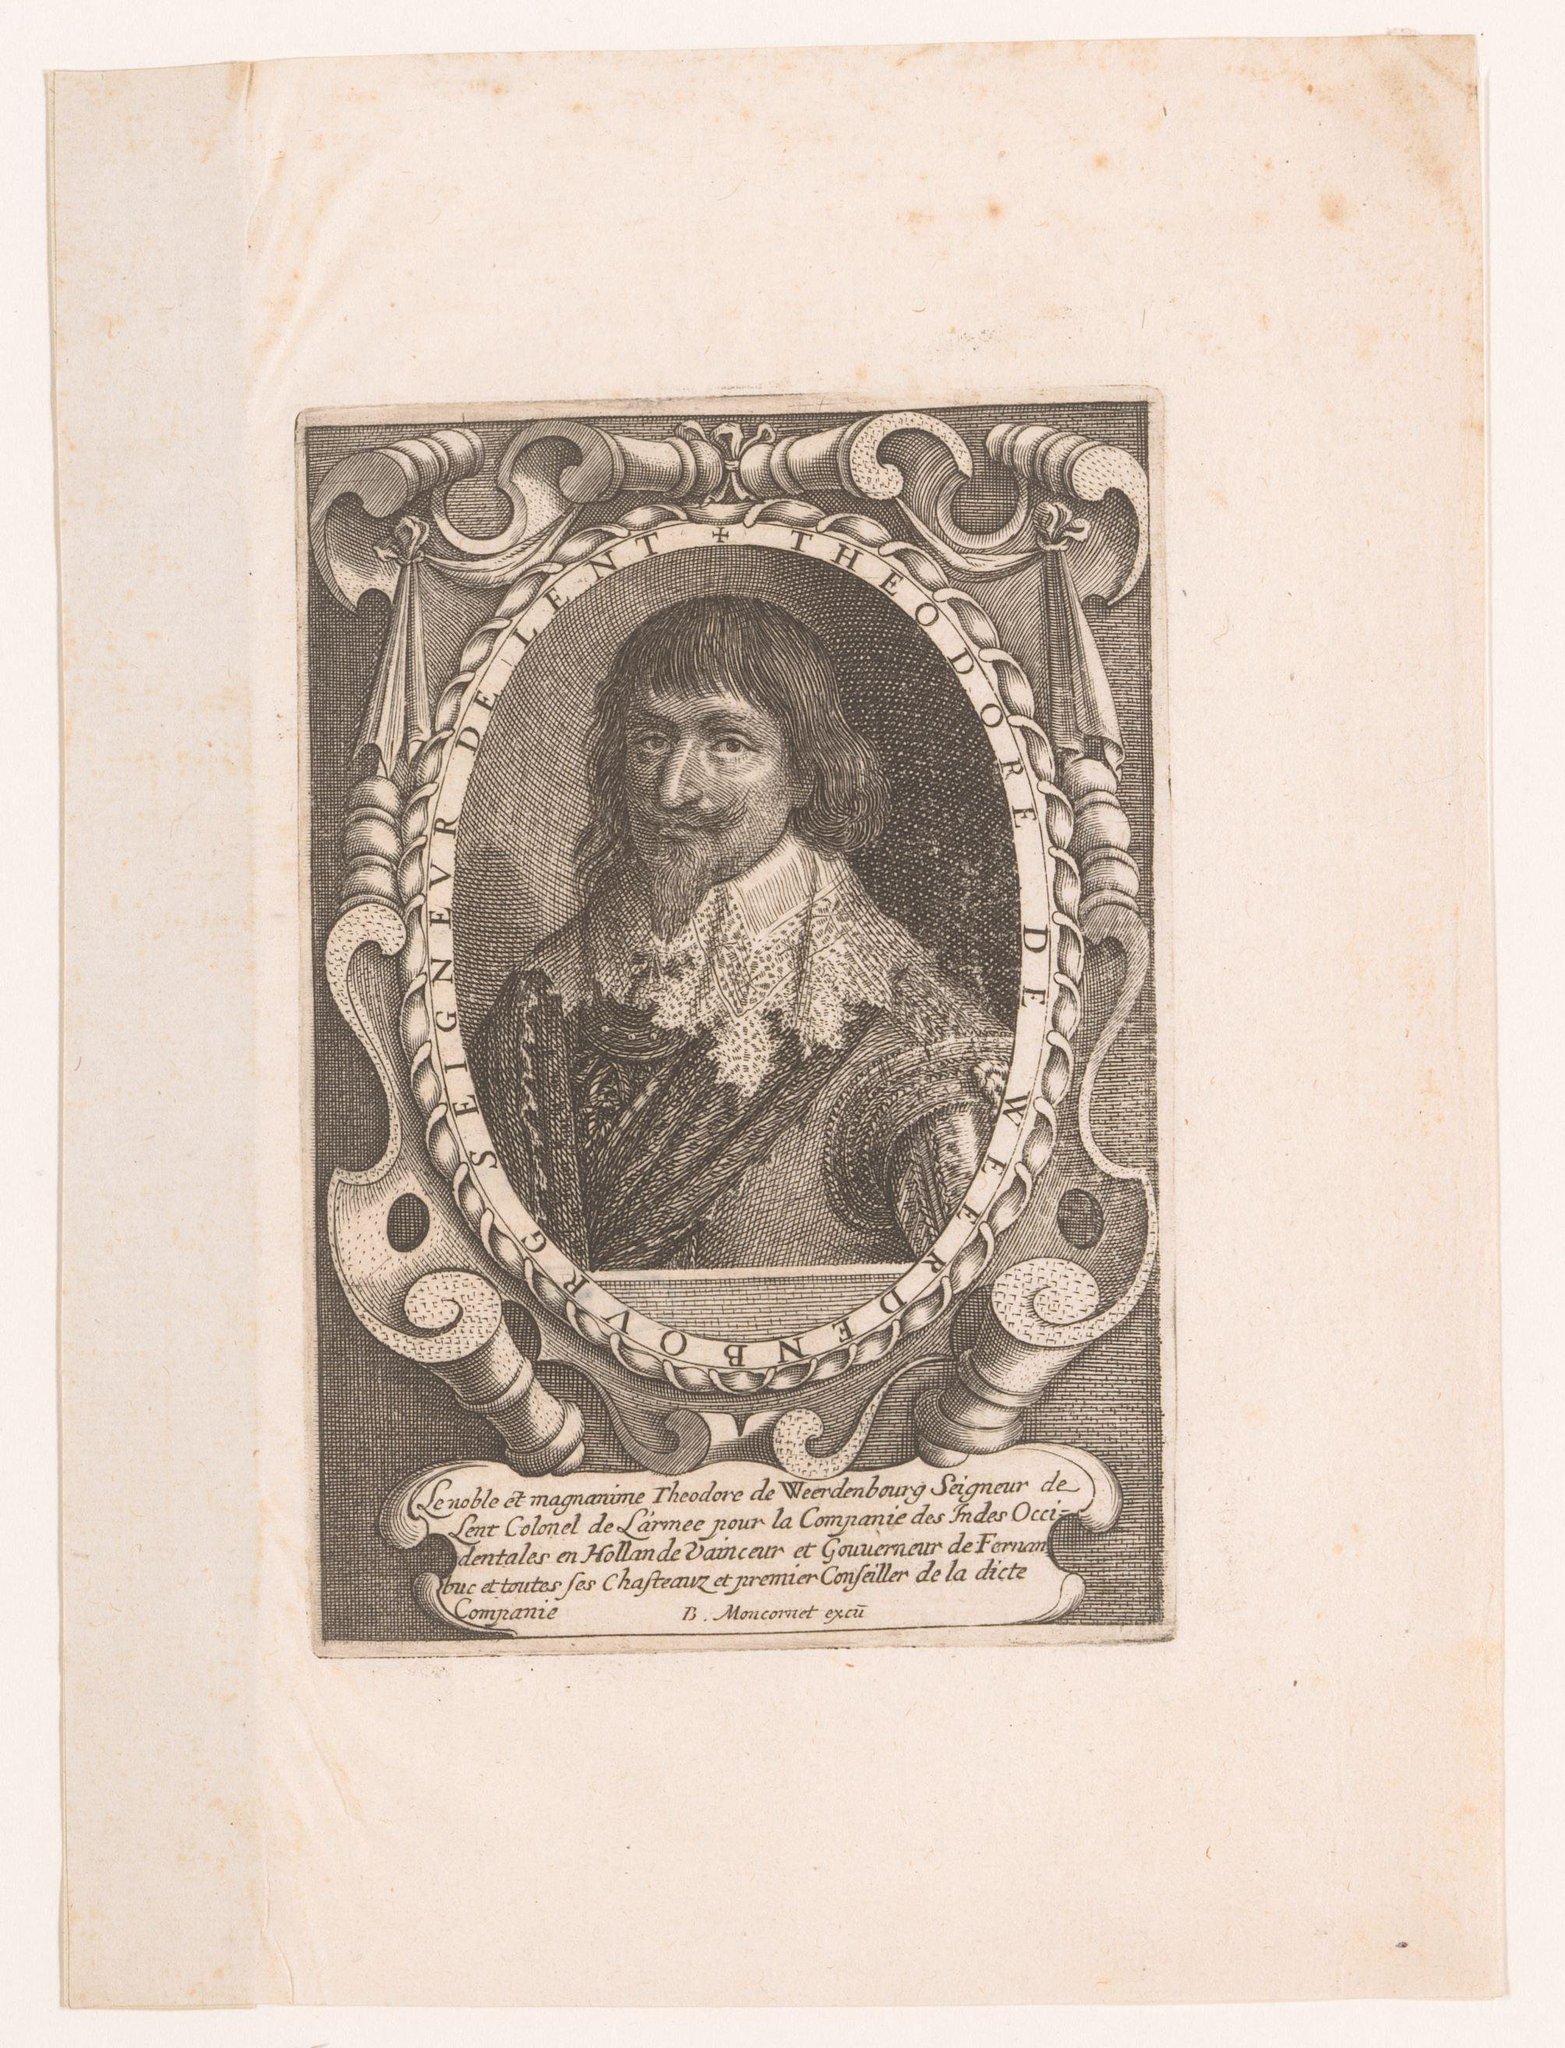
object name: print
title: Portret van Theodorus van Weerdenburg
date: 1610-1668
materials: paper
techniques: engraving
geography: paris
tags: historical persons, nobility and patriciate; chivalry, knighthood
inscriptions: collector's mark: Lugt 2228